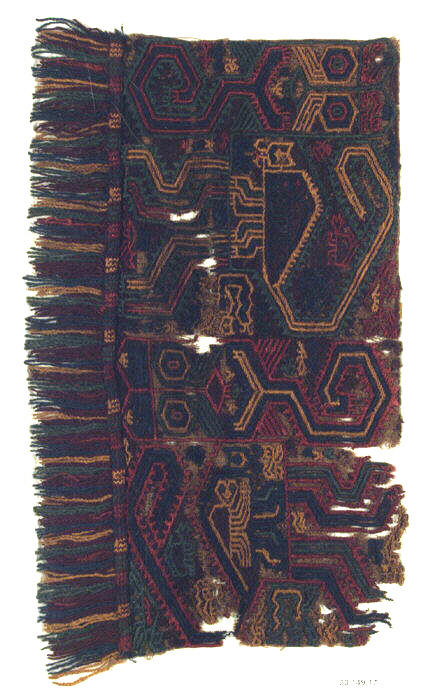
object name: border fragment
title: Embroidered Border Fragment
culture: paracas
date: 500-101 BCE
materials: animal fiber, cotton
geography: peru